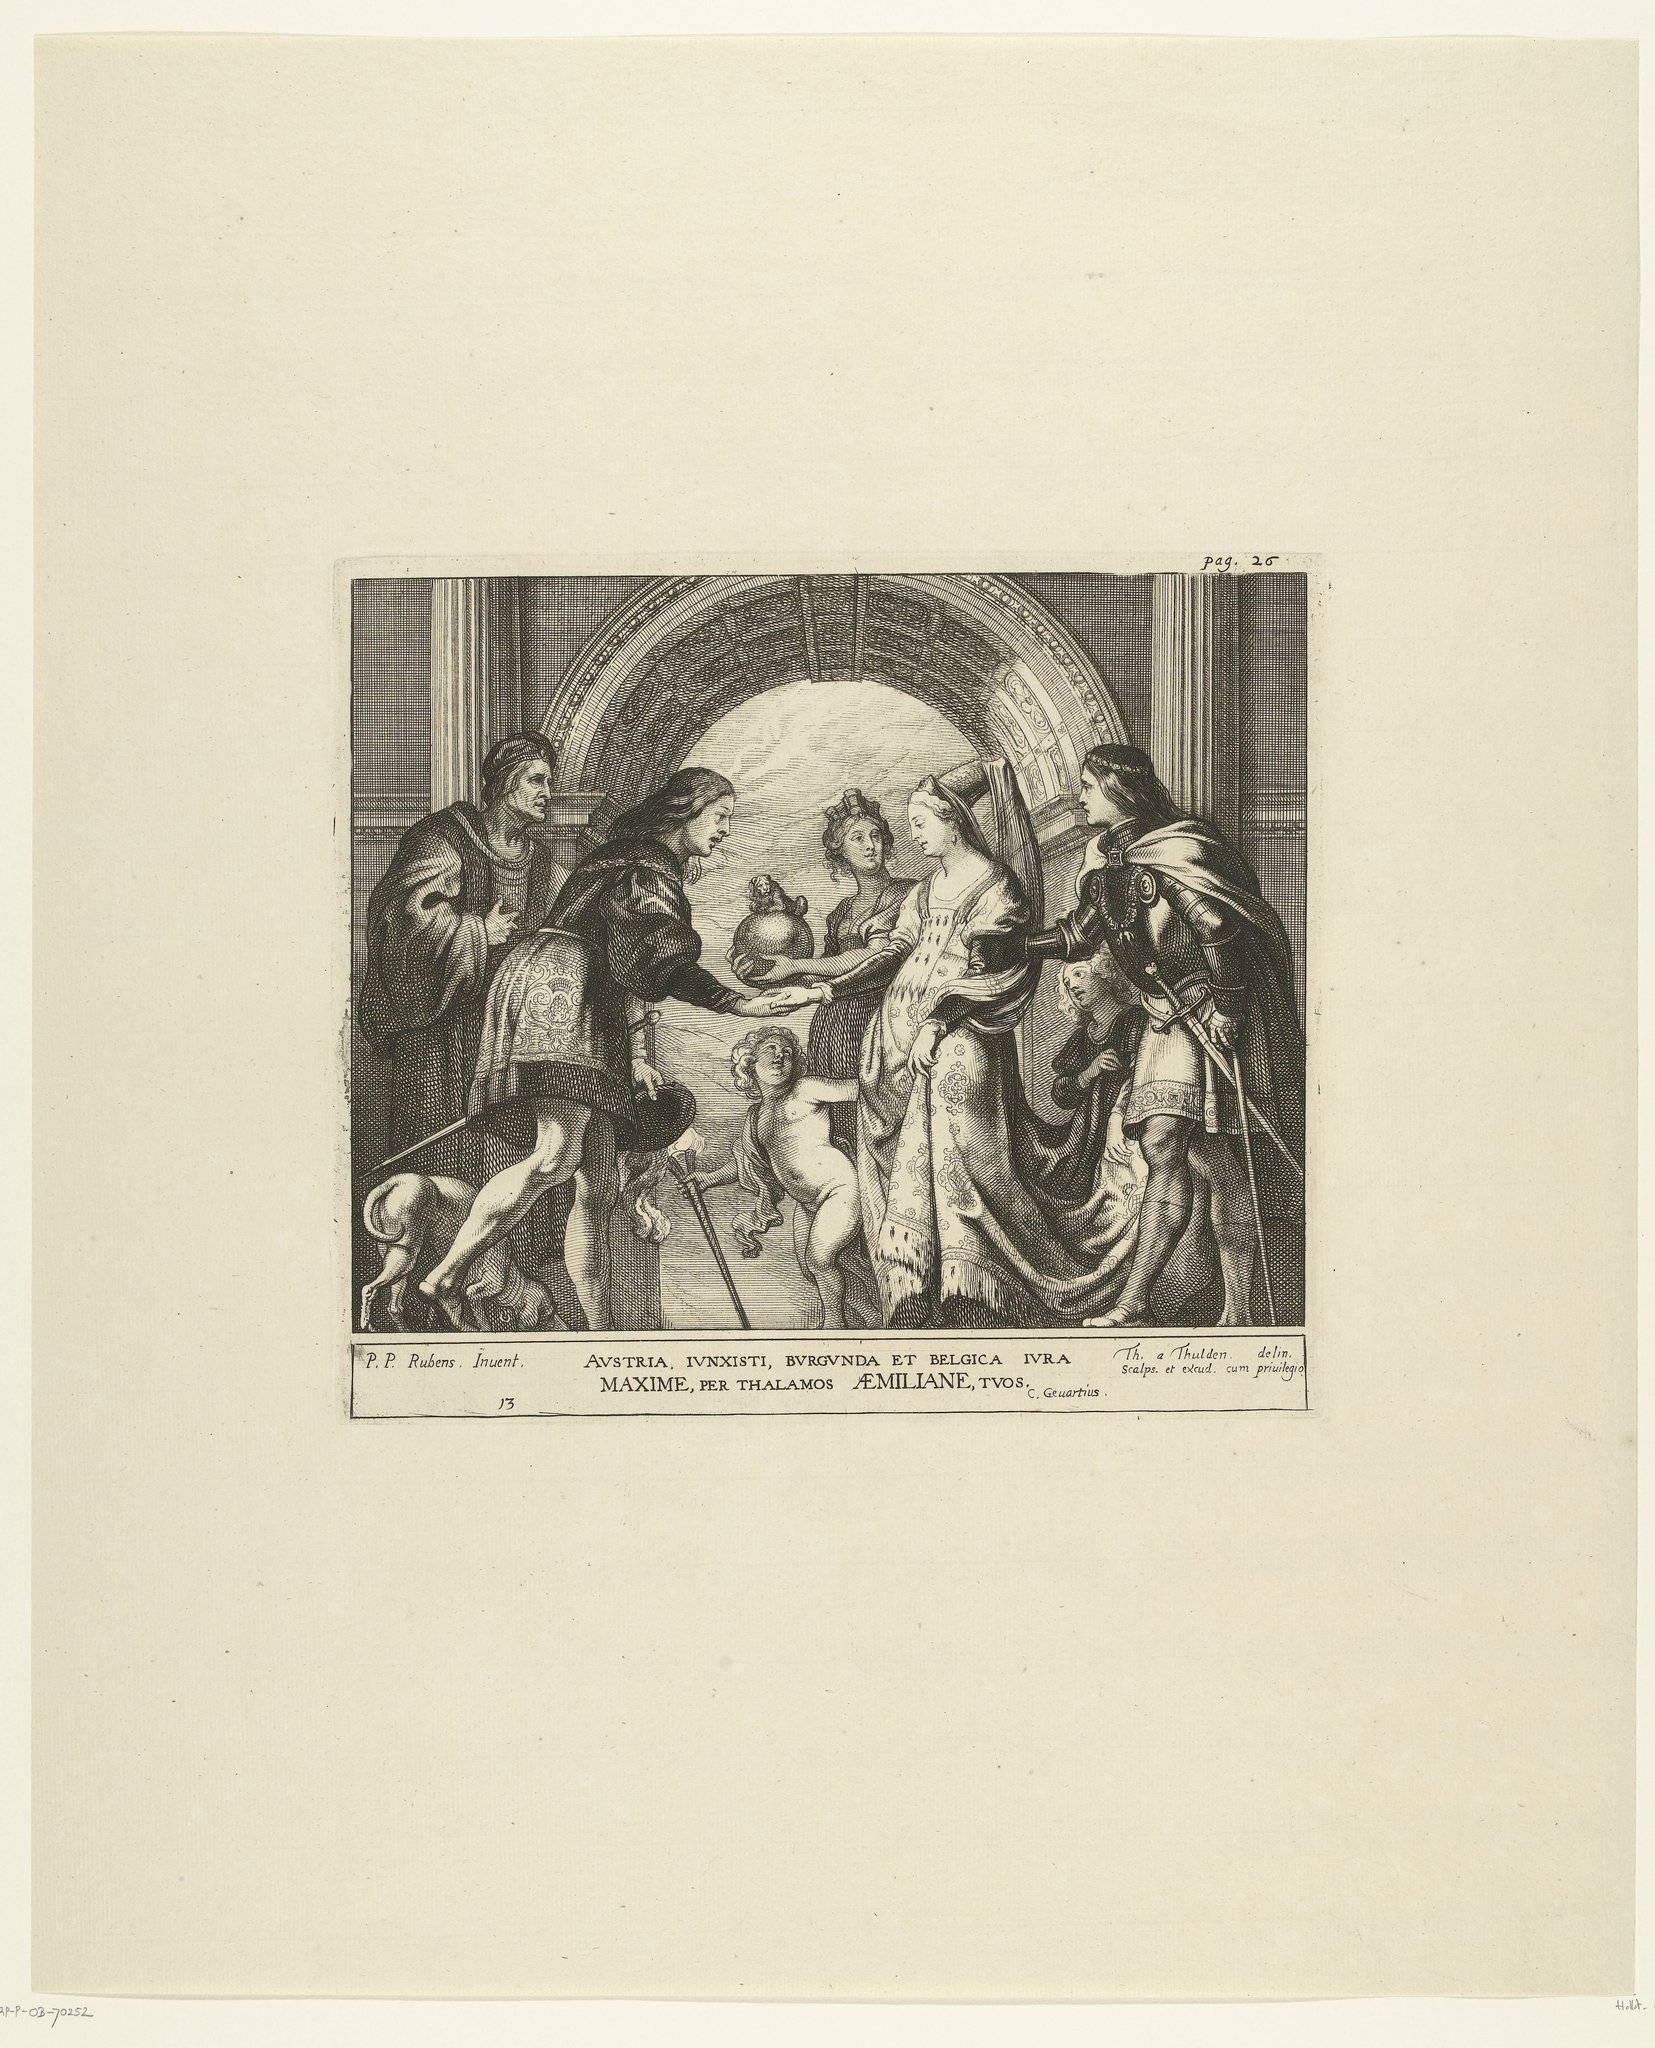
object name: print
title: Conjugium Maxaemiliani, Archiducis Austriae, cum Maria Belgarum ac Burgondionum Principe: Media Arcus Tabula, maiori formâ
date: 1639-1641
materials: paper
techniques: engraving, etching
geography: southern netherlands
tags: bruges, maria (hertogin van bourgondië), maximilian i (holy roman emperor), landvoogd der zuidelijke nederlanden ferdinand van oostenrijk, triumphal arch, antwerp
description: De centrale voorstelling met het huwelijk tussen Maximiliaan en Maria van Bourgondië in 1477. In de voorzijde van de triomfboog van Filips op de hoek van de Huidevetterstraat en de Meir. Gemerkt rechtsboven: pag. 26. Met onderschrift van 2 regels het Latijn. Blad nr. 13 in een geheel van 43 platen die de uitgave van de beschrijving van de intocht van de Kardinaal Infant Ferdinand van Oostenrijk te Antwerpen op 17 april 1635 als de nieuwe landvoogd voor de Spaanse Nederlanden illustreren.